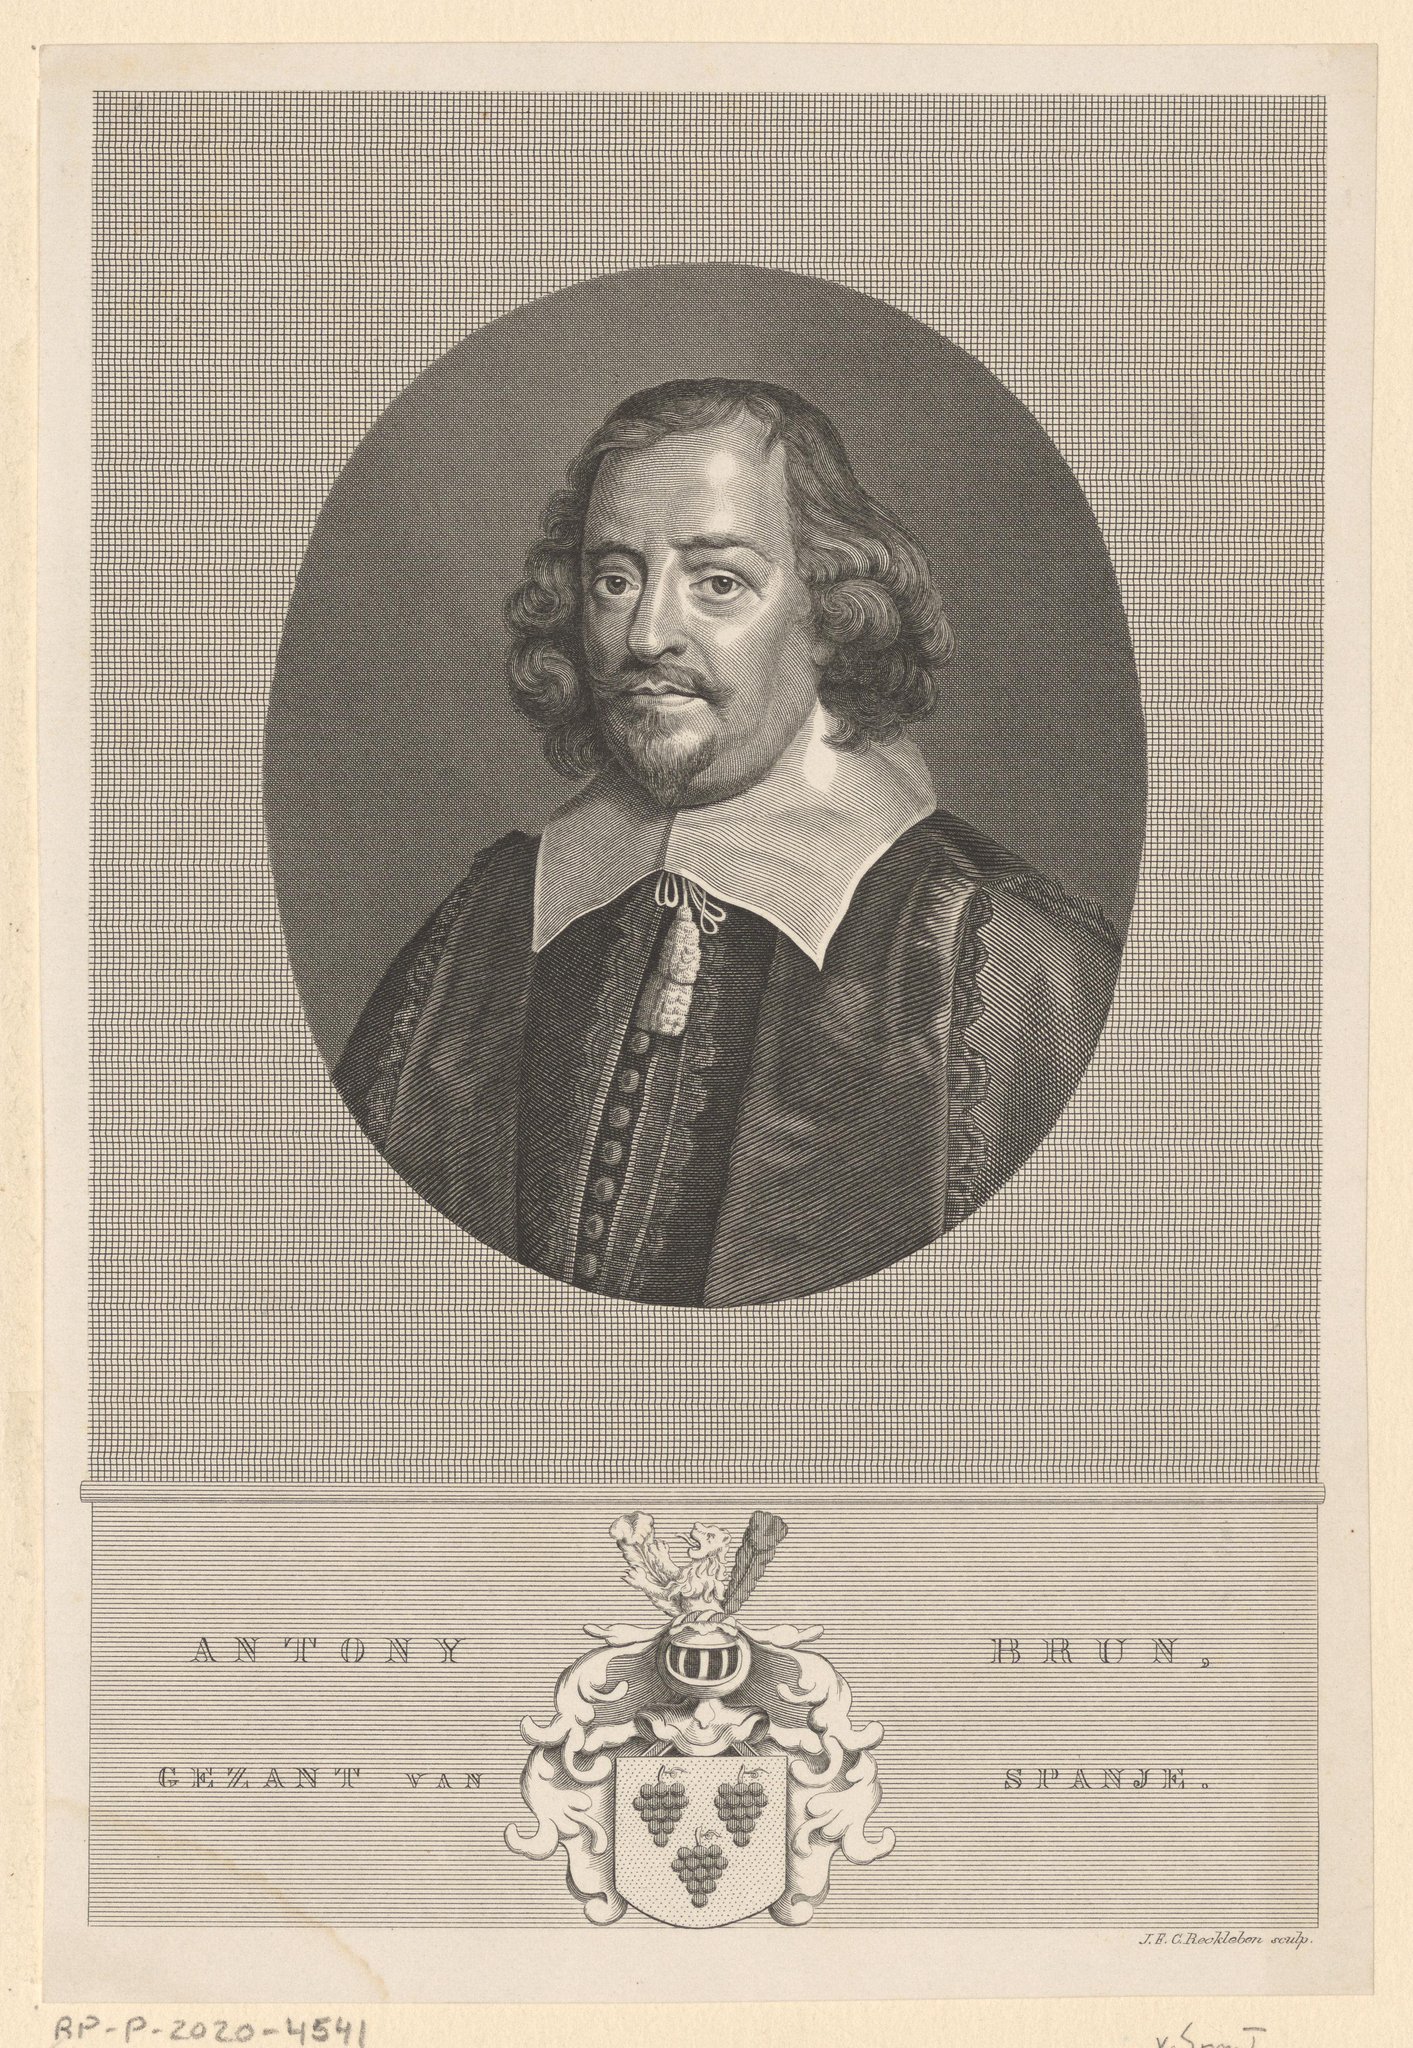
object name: print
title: Portret van Anthoine Brun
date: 1879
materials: paper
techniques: engraving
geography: haarlem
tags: historical persons, armorial bearing, heraldry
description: Prent uit: Arend, Johannes Pieter. Algemeene geschiedenis des vaderlands van de vroegste tijden tot op heden. Haarlem: Jan de Haan, 1879, dl. 4-1.